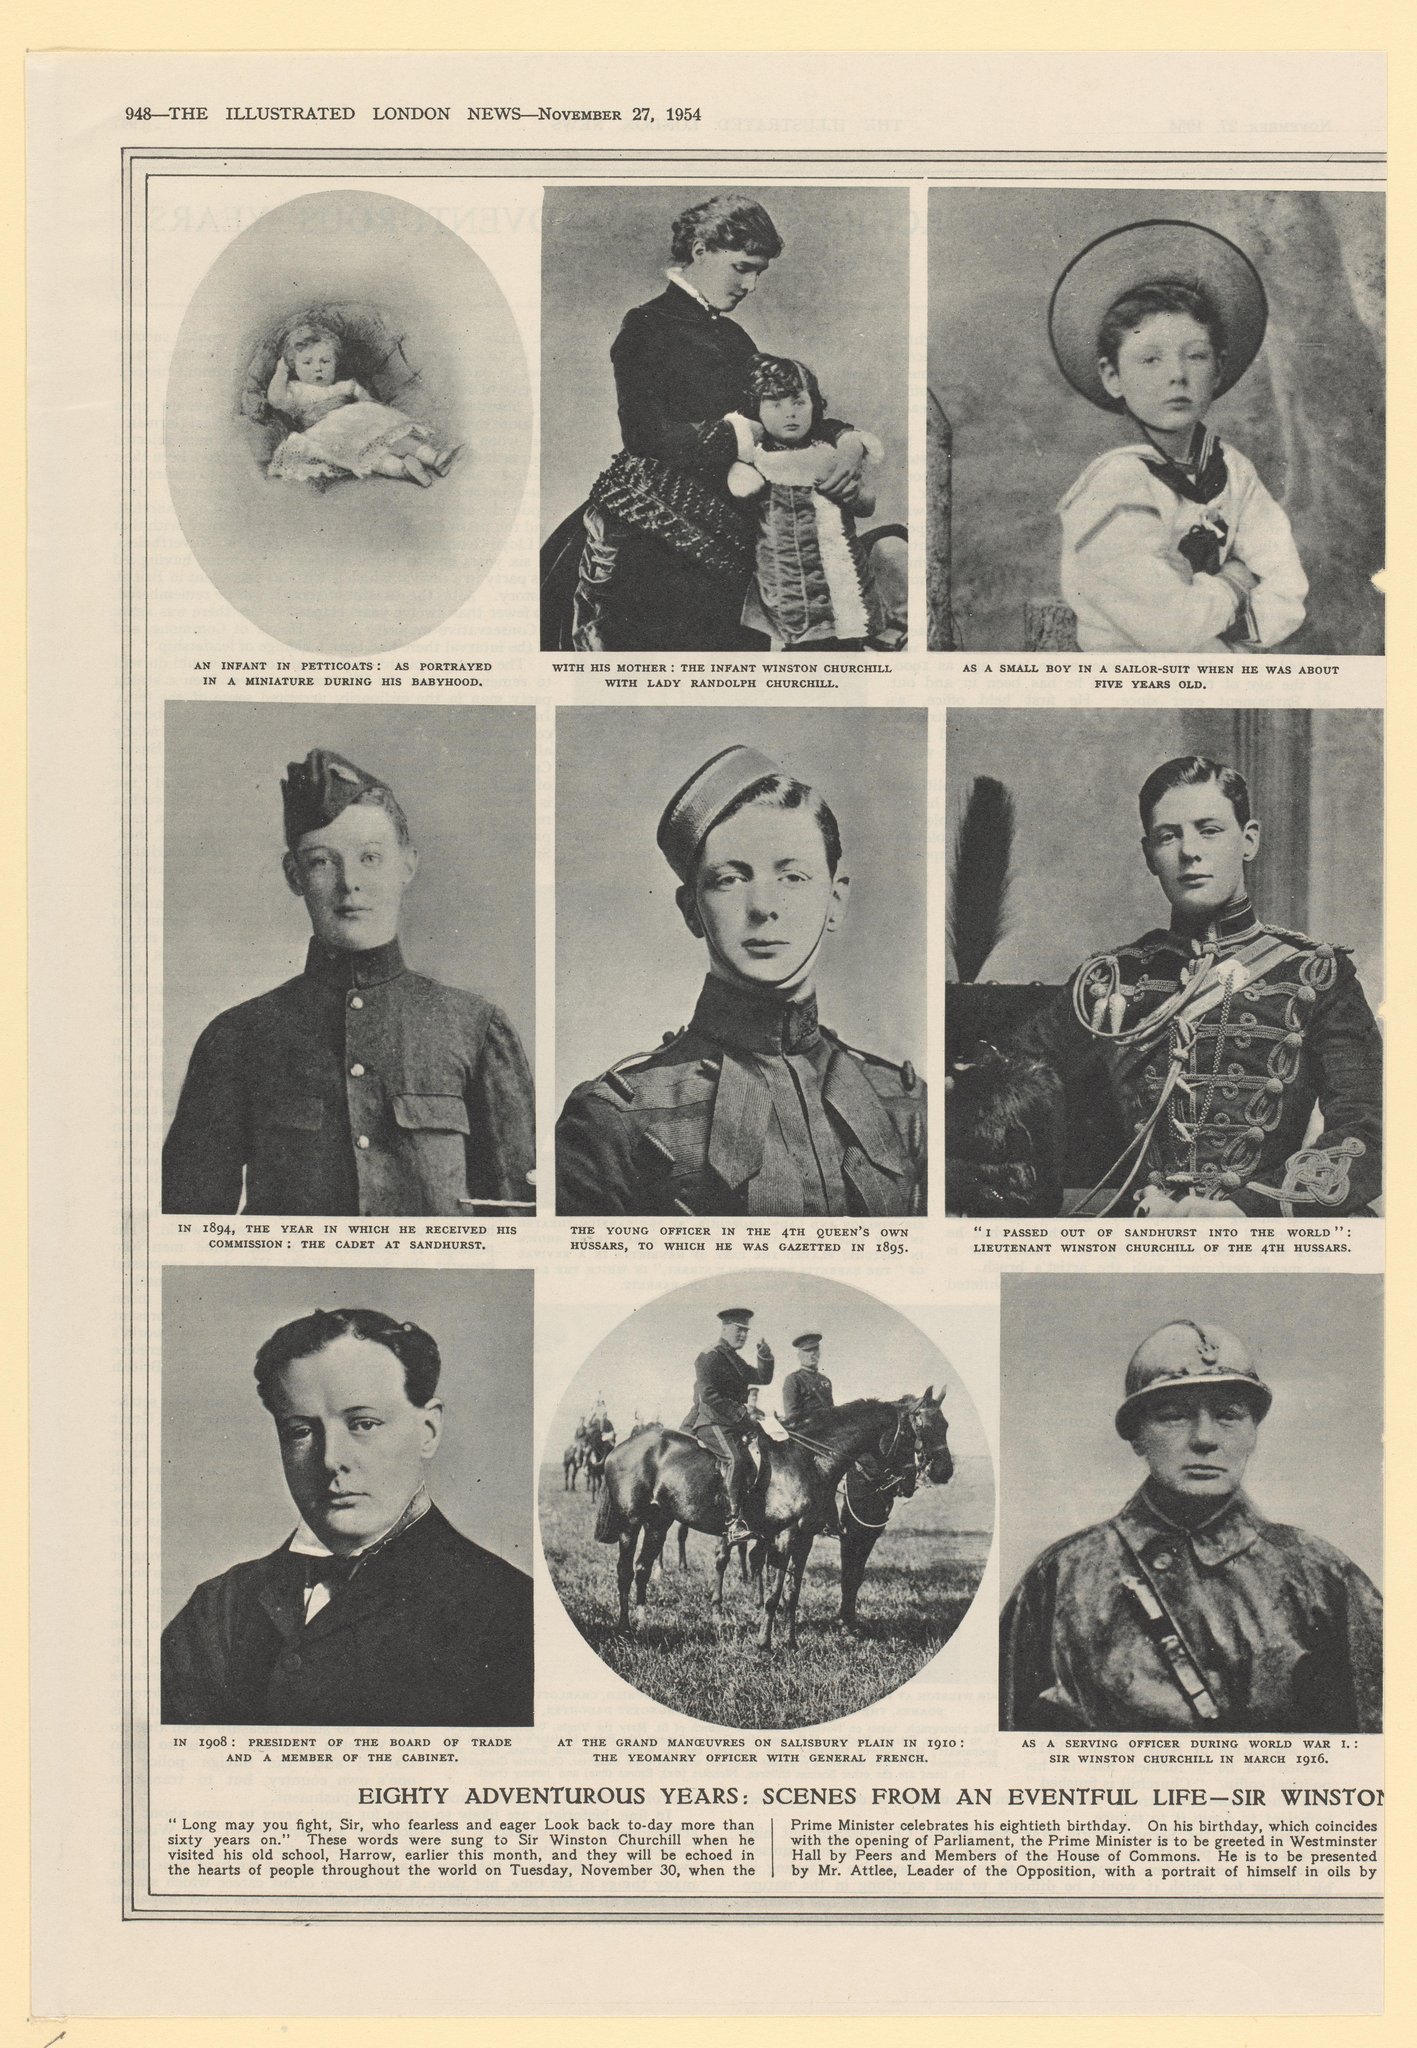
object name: photomechanical print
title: Negen portretten van Winston Churchill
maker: Anonymous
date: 1874-1954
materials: paper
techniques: rotogravure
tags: weekly, monthly, magazine, etc., historical persons, politician, e.g. party leader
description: Bladzijde uit 'Supplement to the Illustrated London News' van 27 november 1954 met negen portretten van Winston Churchill, van zijn jeugd tot en met de Eerste Wereldoorlog.